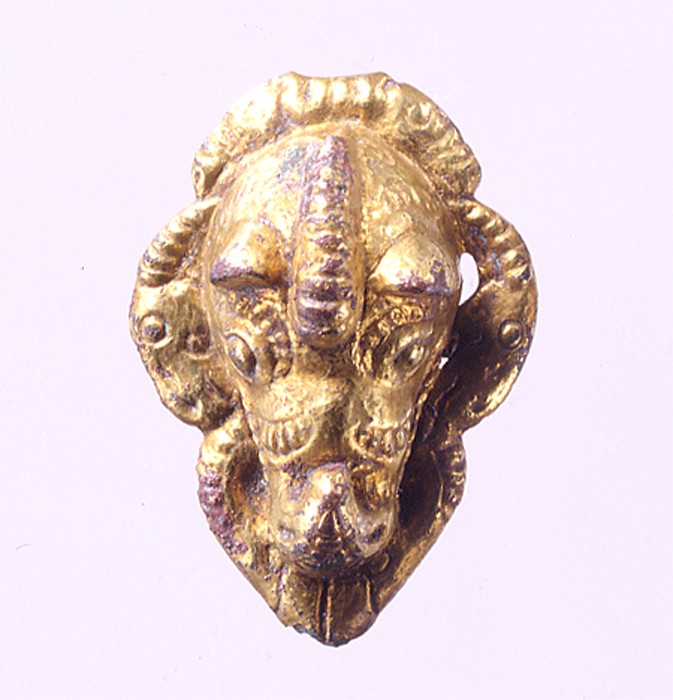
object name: harness fitting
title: Harness Fitting with Zoomorphic Motif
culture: north chinese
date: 300-201 BCE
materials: bronze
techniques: gilding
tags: animals